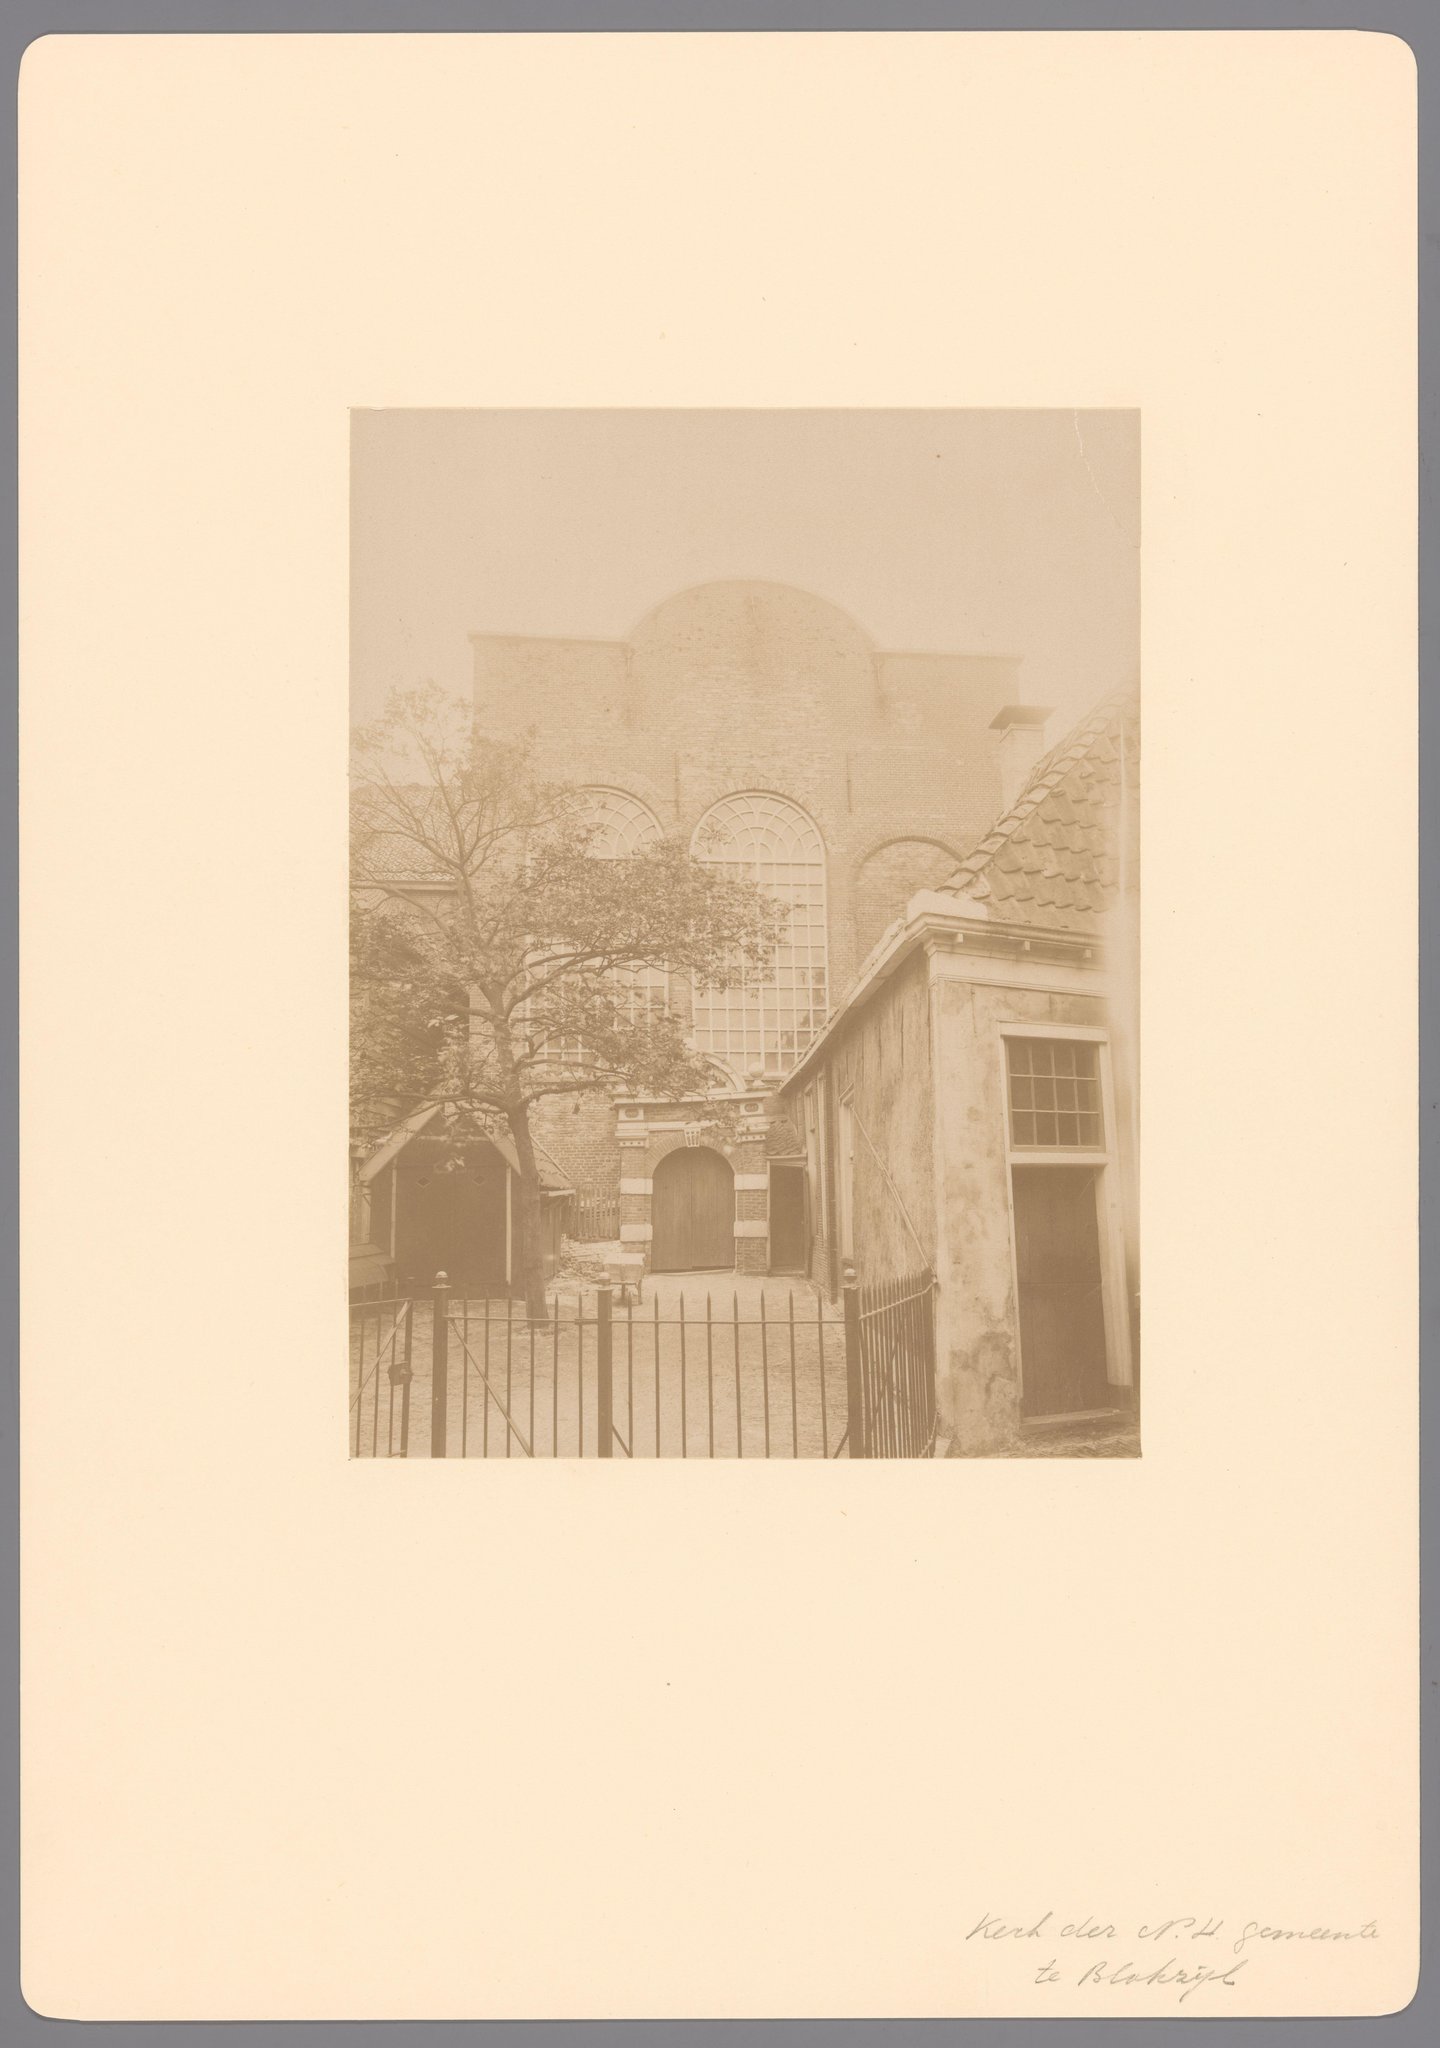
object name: photograph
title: Gevel van de Hervormde Kerk te Blokzijl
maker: anoniem (monumentenzorg)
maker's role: fotograaf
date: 1890-1910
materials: cardboard, photographic support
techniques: albumen print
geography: blokzijl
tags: church (exterior)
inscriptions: annotation: ‘Kerk der N.H. gemeente te Blokzijl’